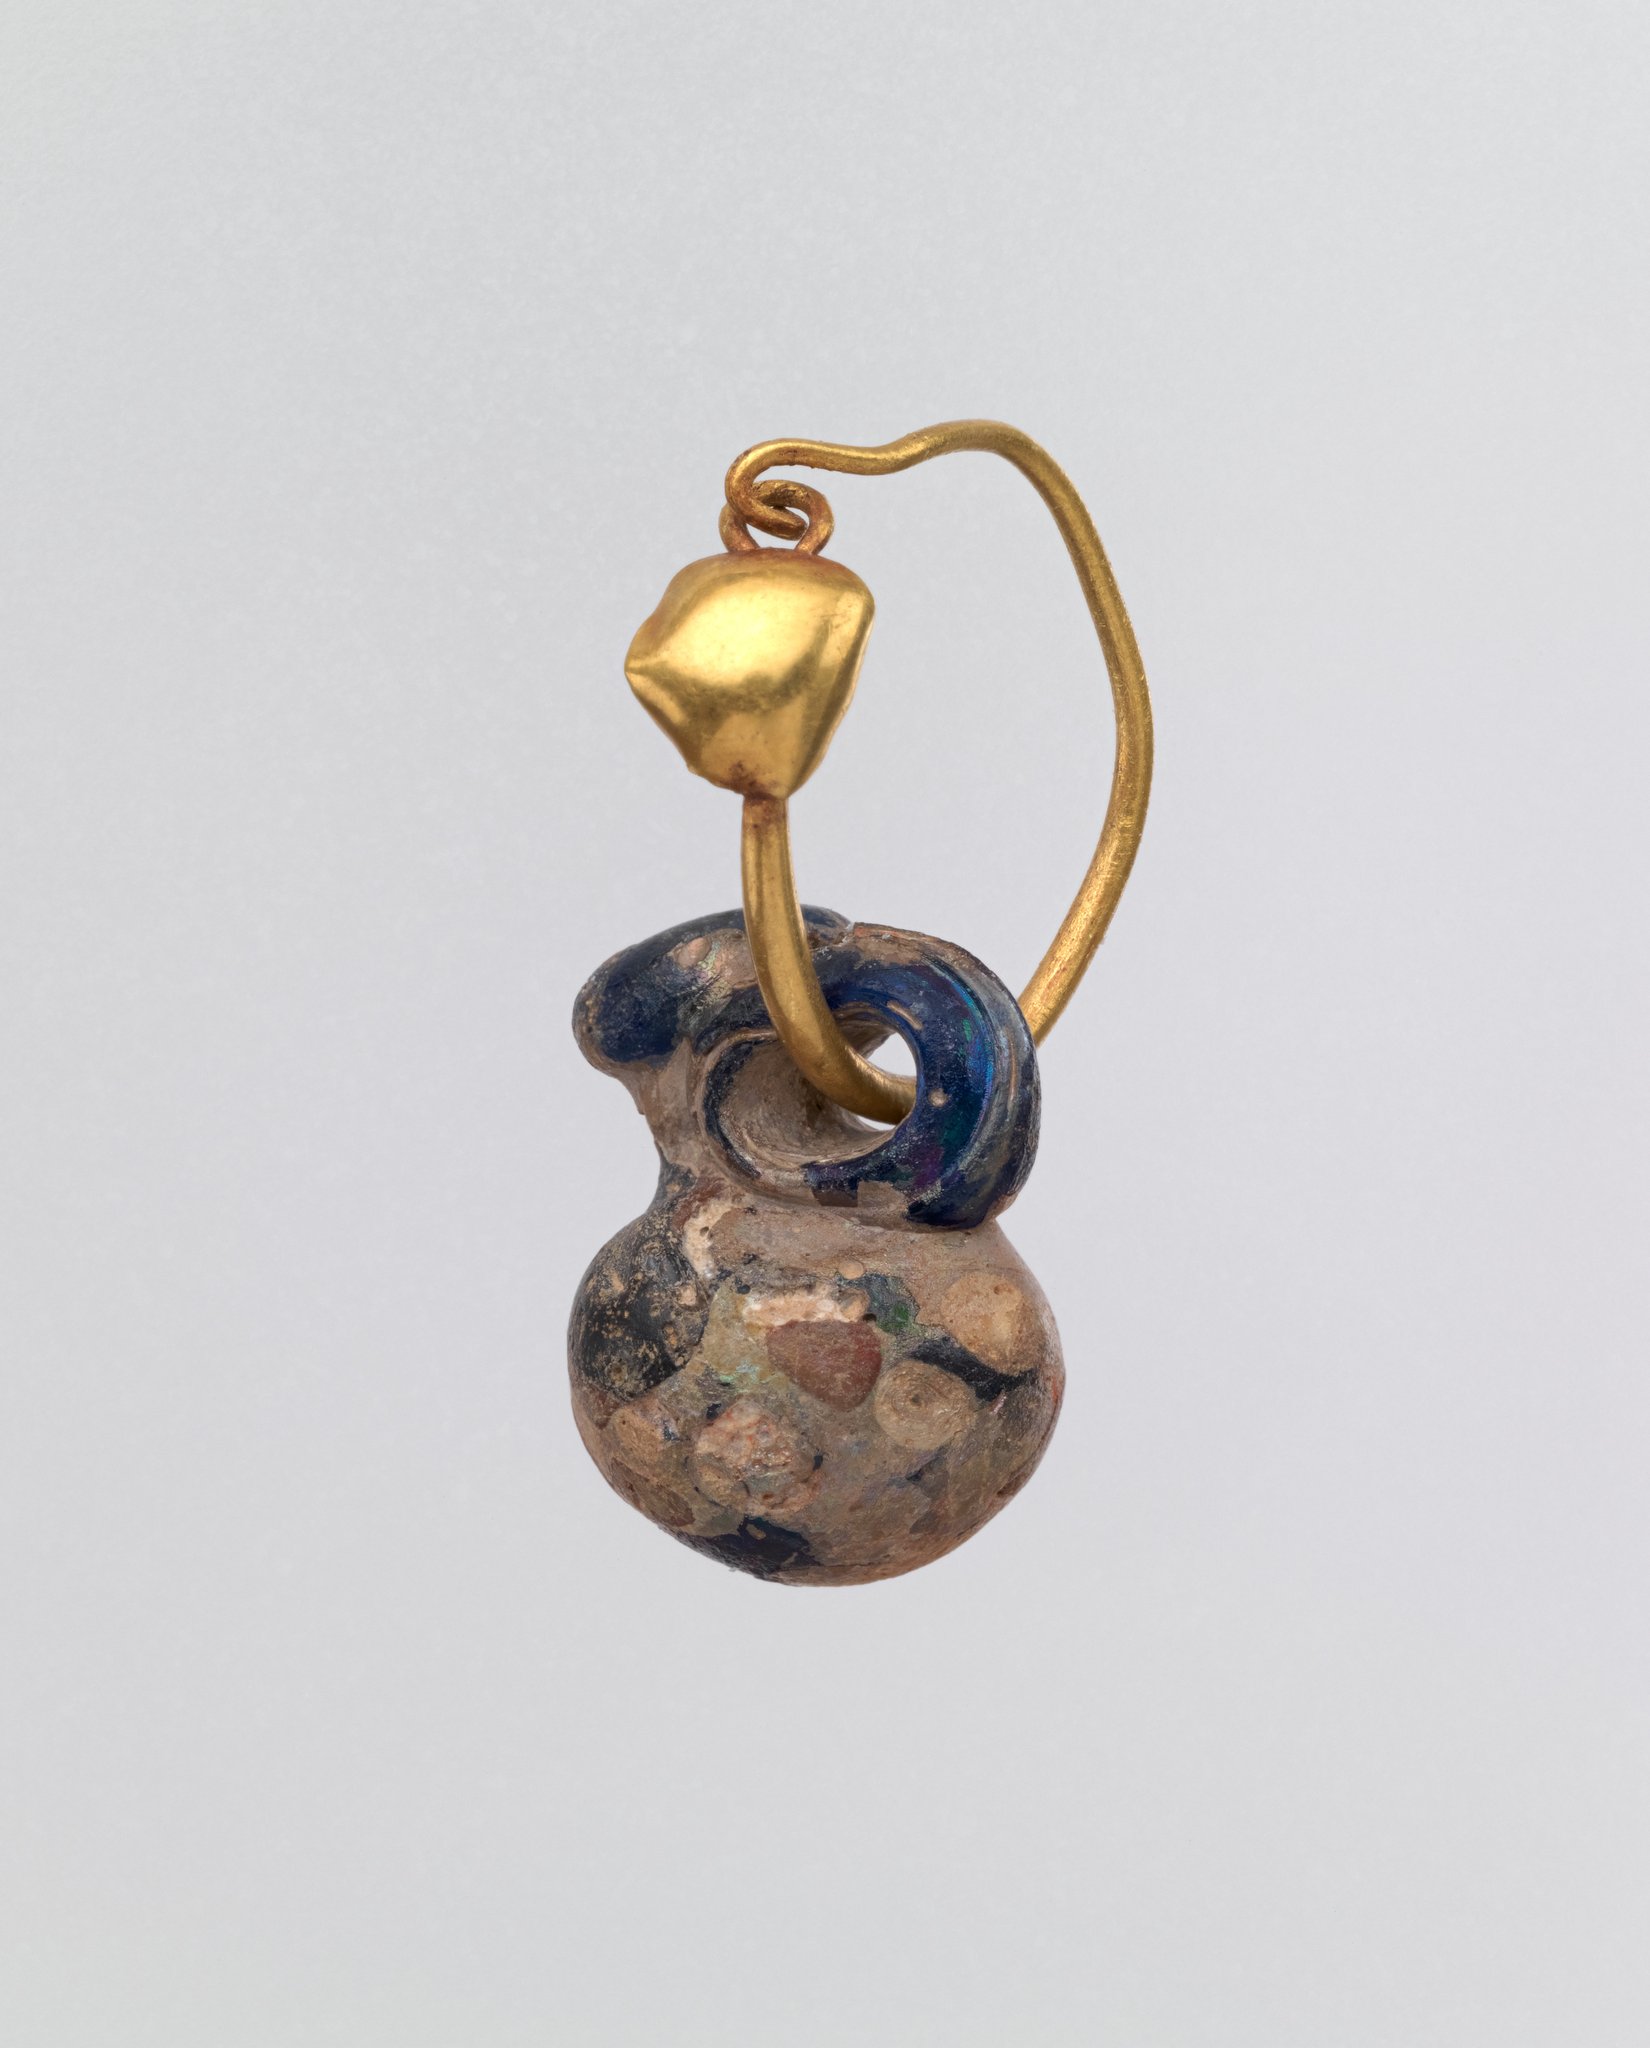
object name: earring with pendant of jug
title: Gold earring with glass pendant in the form of a miniature jug or gourd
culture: roman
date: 301-500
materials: glass, gold